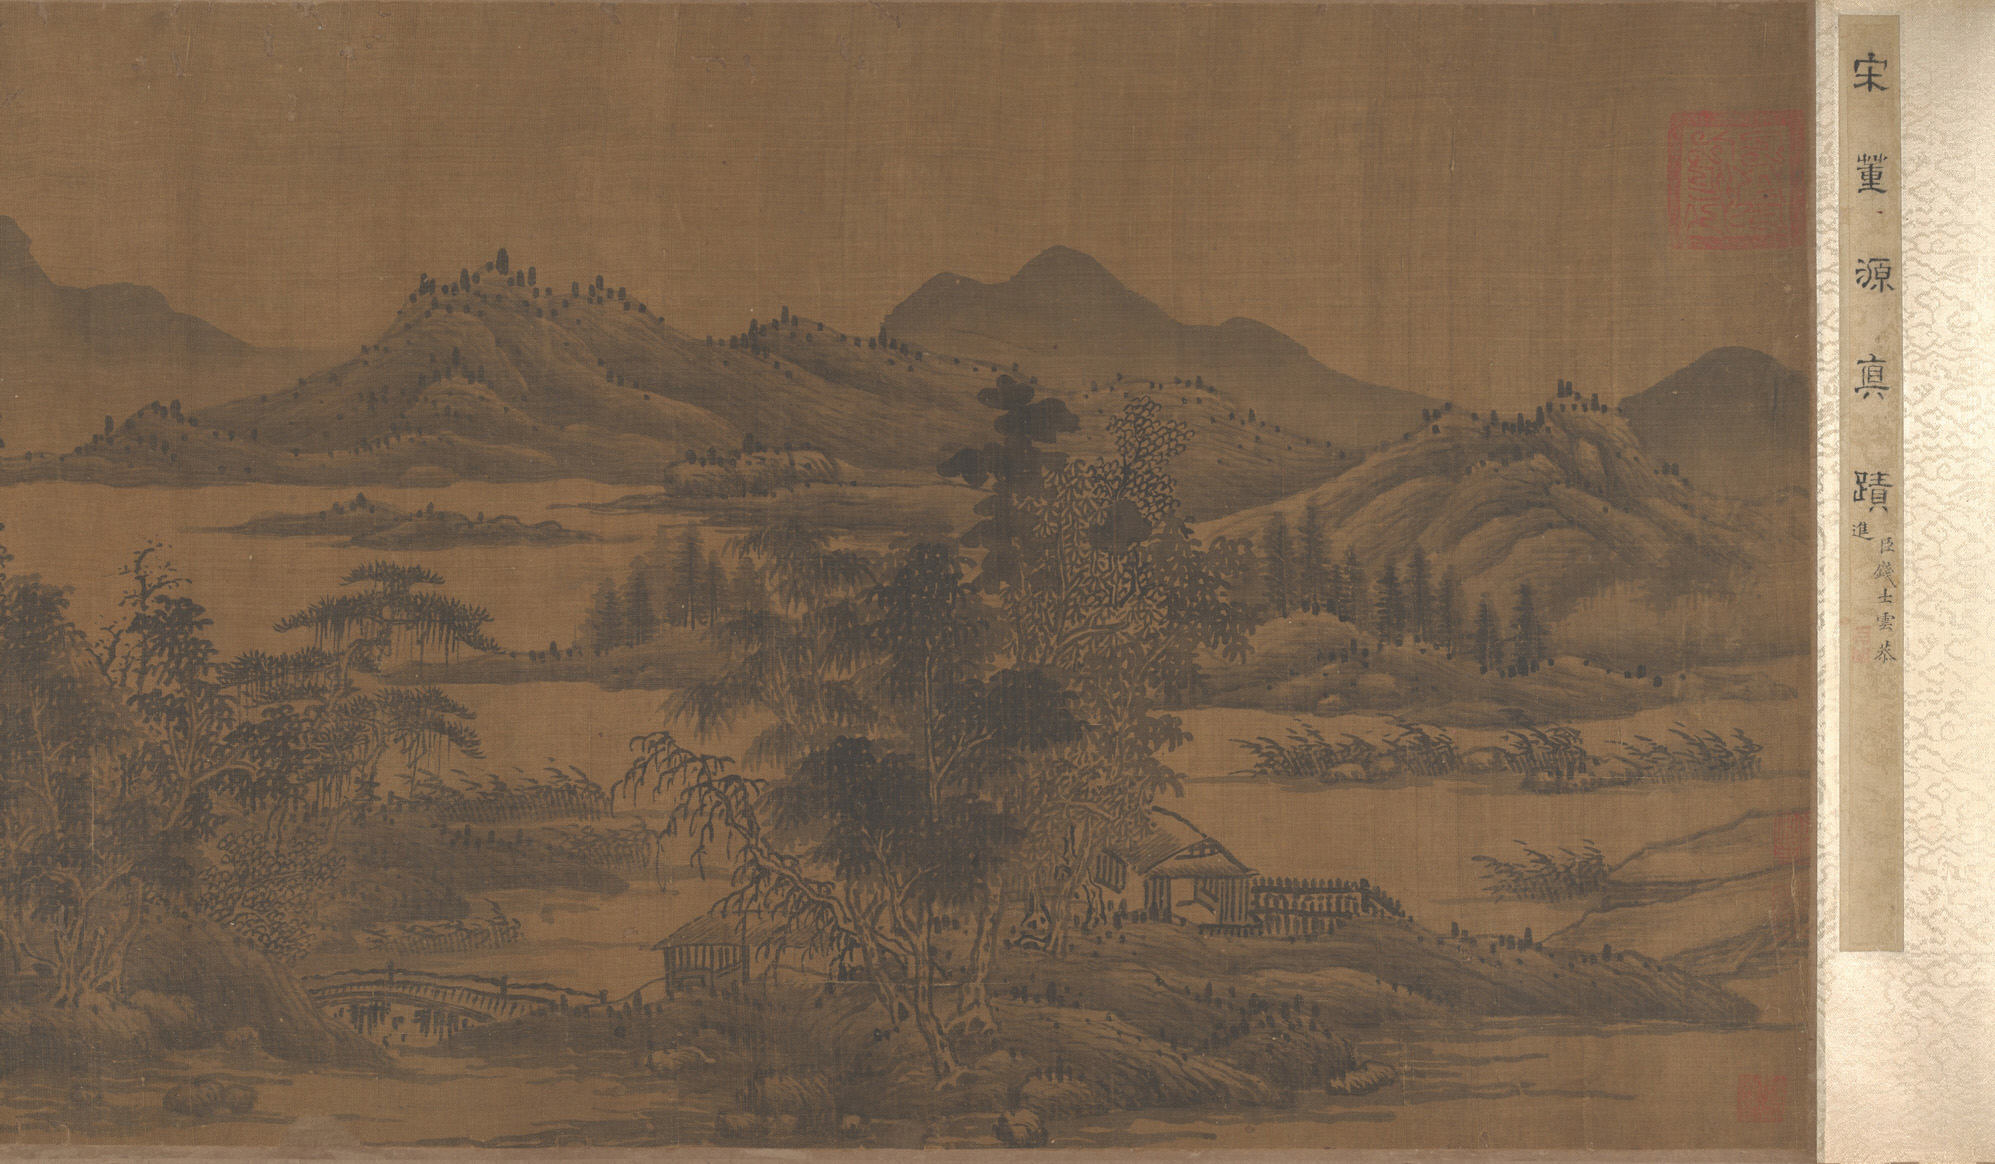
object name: handscroll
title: Landscape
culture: chinese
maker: unidentified artist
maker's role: artist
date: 1601-1700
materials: ink, silk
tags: landscapes